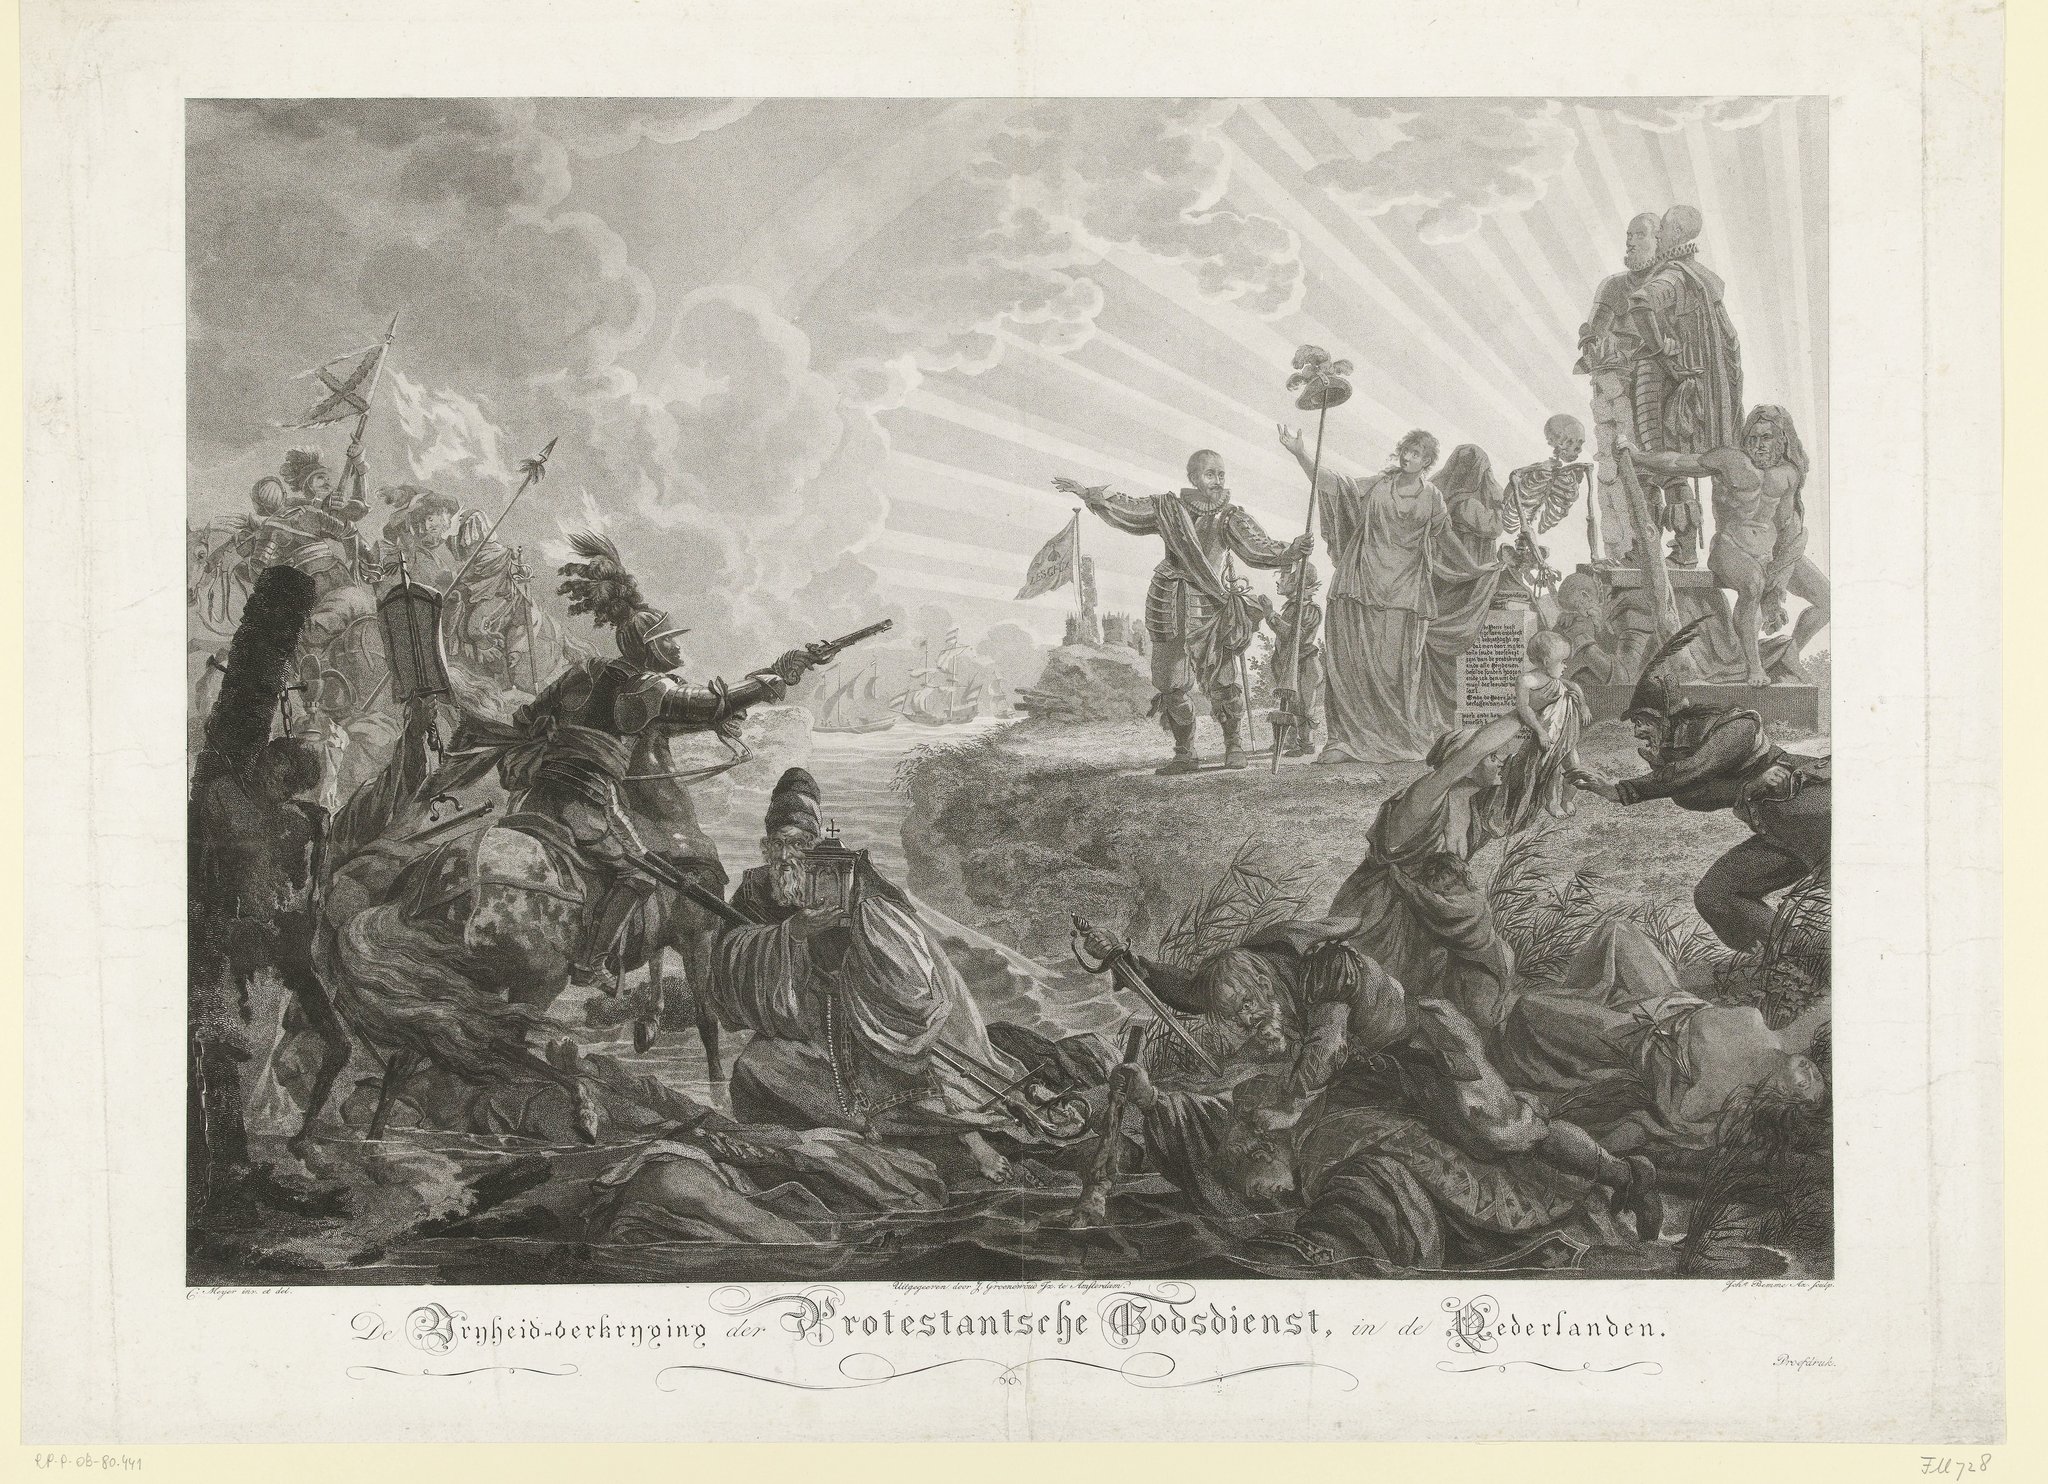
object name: print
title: De Vrijheid-verkrijging der Protestantsche godsdienst, in de Nederlanden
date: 1817-1827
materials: paper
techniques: stippled etching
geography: amsterdam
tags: delft, william i (prince of orange), fernando álvarez de toledo (3rd duke of alba), brussels, earl, reformation (roman catholic church vs. protestantism), execution of heretic, e.g. by burning at the stake, 'auto-da-fé'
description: Allegorie op de verkregen vrijheid van de Protestantse godsdienst in de Nederlanden in 1577. Prins Willem I met lans en vrijheidshoed bij de personificatie van de Godsdienst voor een monument voor de strijd voor vrijheid van geloof met de graven van Egmond en Horne staande op de knielende Alva, in zonnestralen. Achter de prins de vlag van de geuzen. Hierbij ook de Dood en Hercules. Rechts razende moordende soldaten, een moeder met kinderen, een krijgsman doodt een katholieke priester (mogelijk een verwijzing naar de martelaren van Gorkum). Centraal een vluchtende geestelijke (verwijzing naar de pauselijke macht). Links een groep ruiters waarvan één zijn pistool op de prins richt, op de achtergrond meer ruiters met een vaandel met het Bougondische kruis. Uiterst links op de voorgrond een slachtoffer van de ketterverbrandingen.